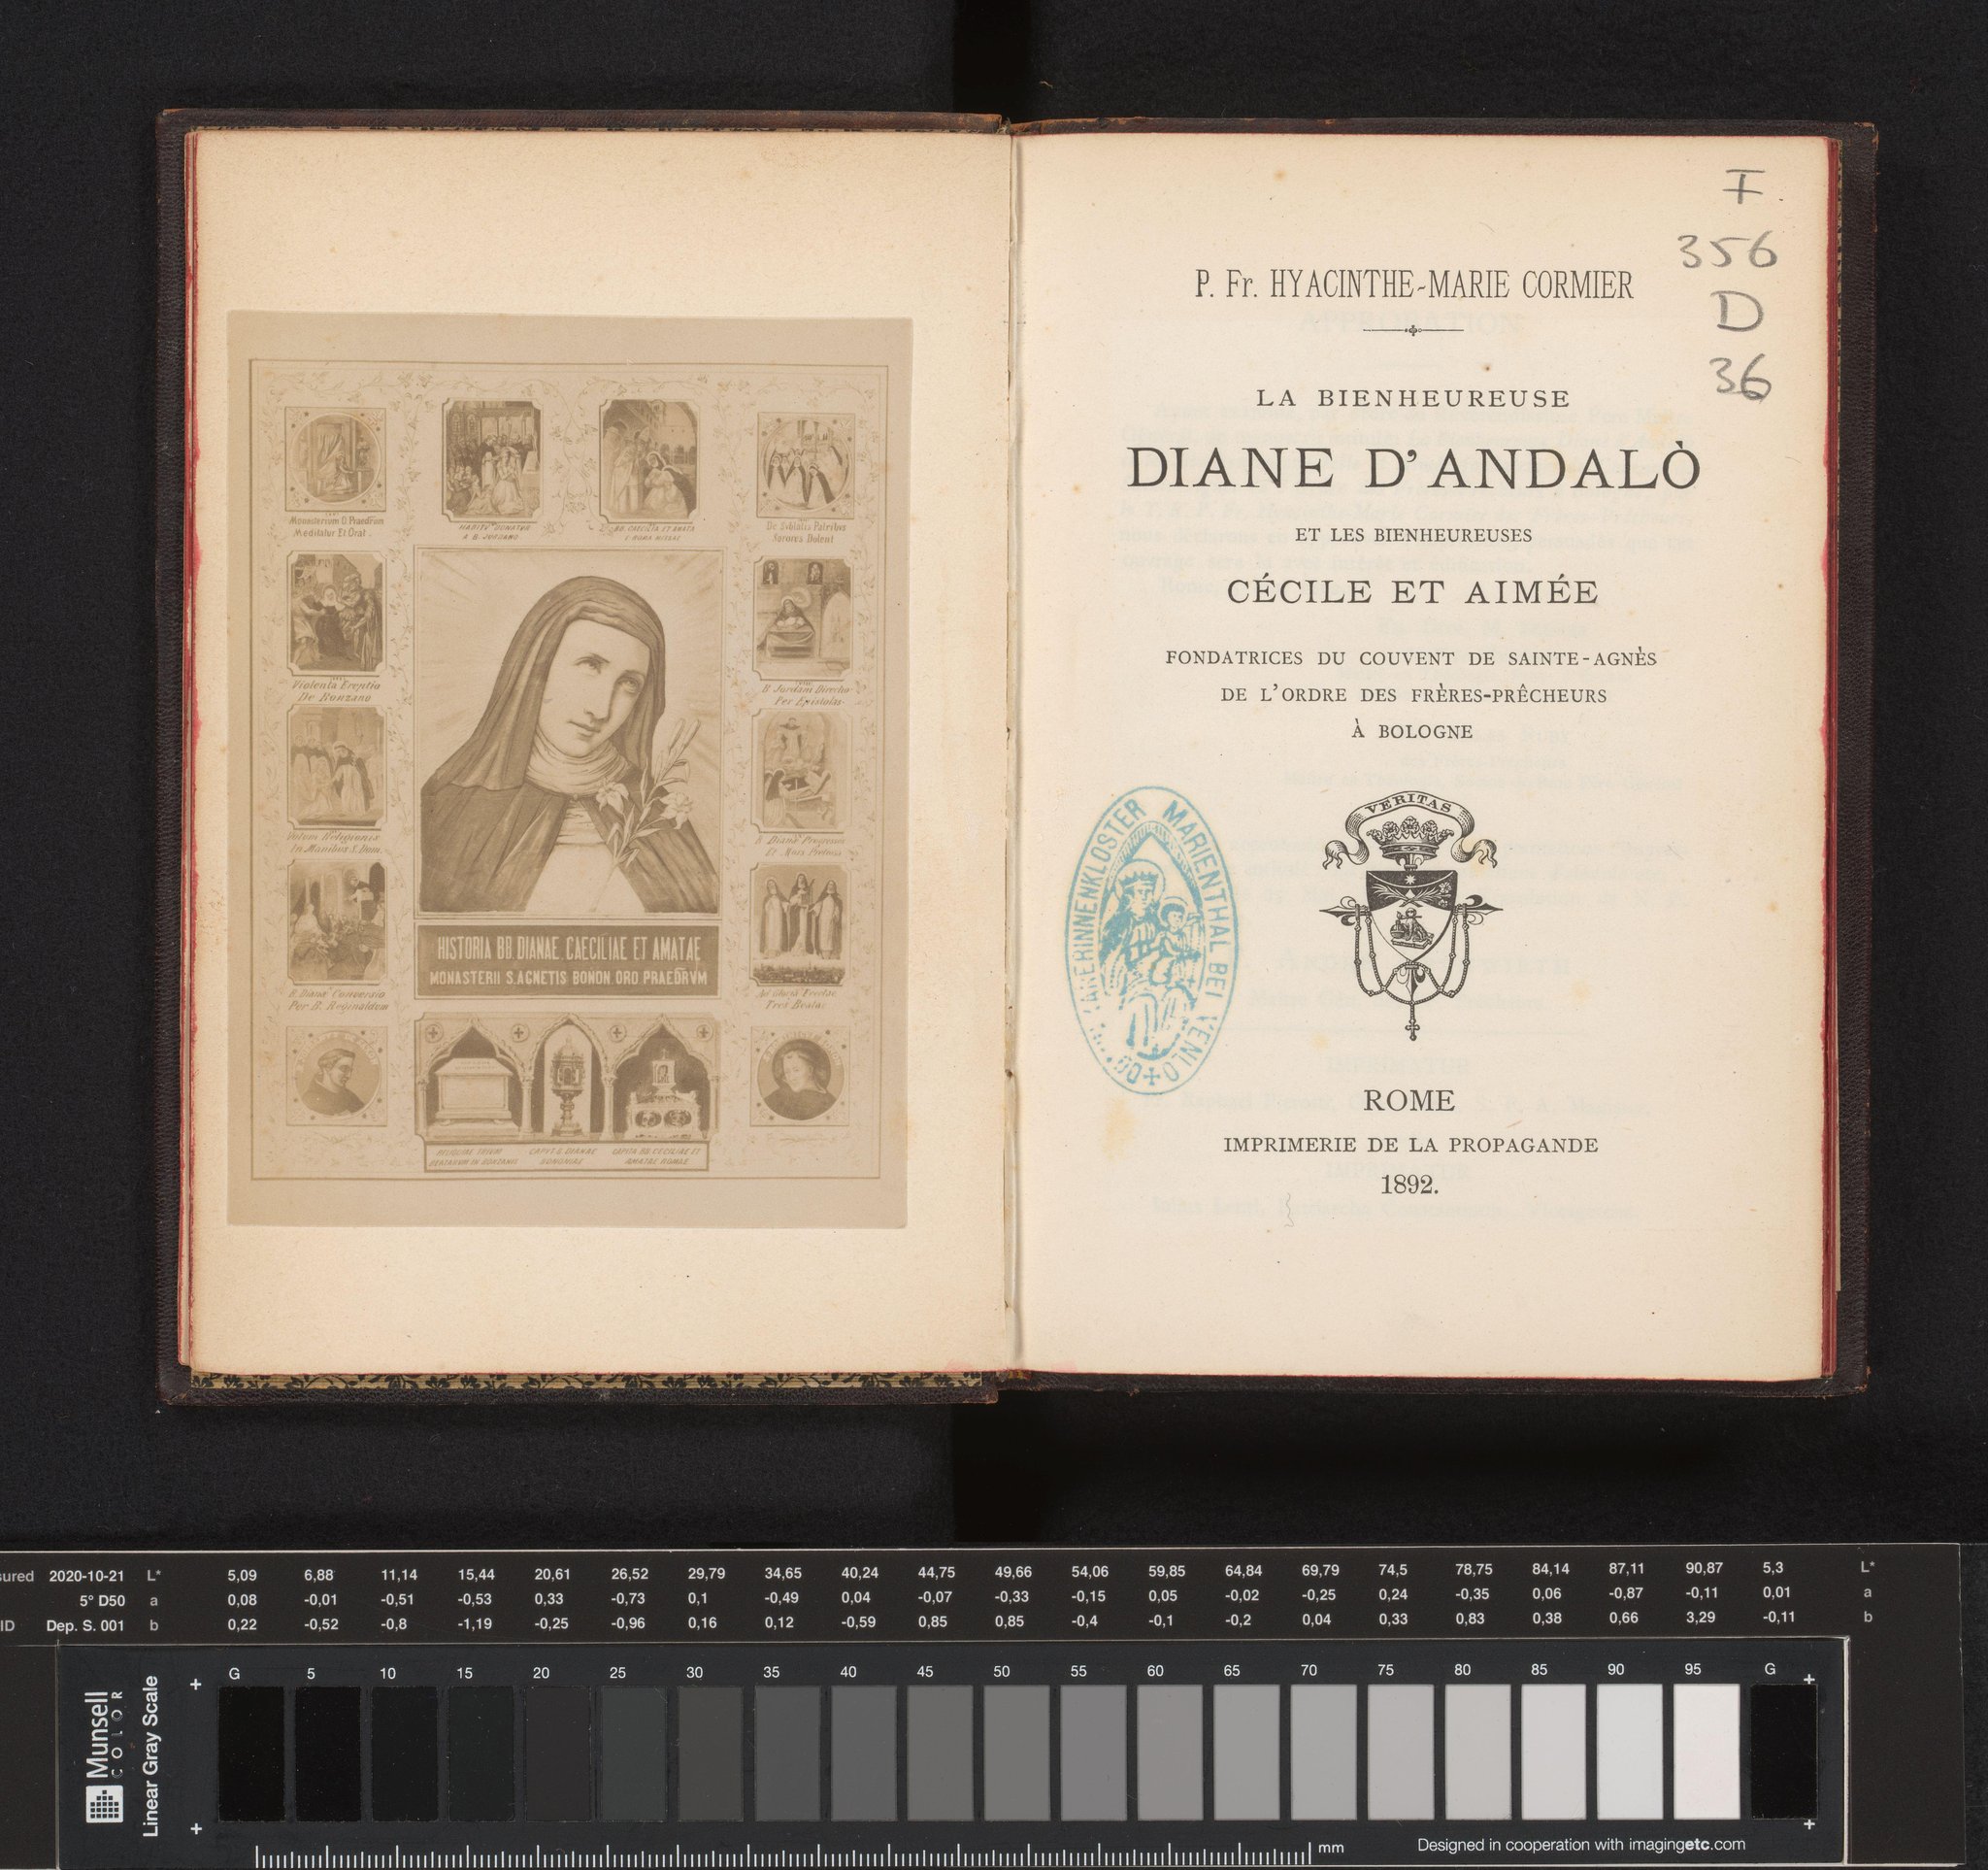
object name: photograph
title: Fotoreproductie van een schilderij, voorstellende een portret en scènes uit het leven van de heilige Diana d'Andalo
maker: Anonymous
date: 1882-1892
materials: photographic support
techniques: albumen print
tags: female saints